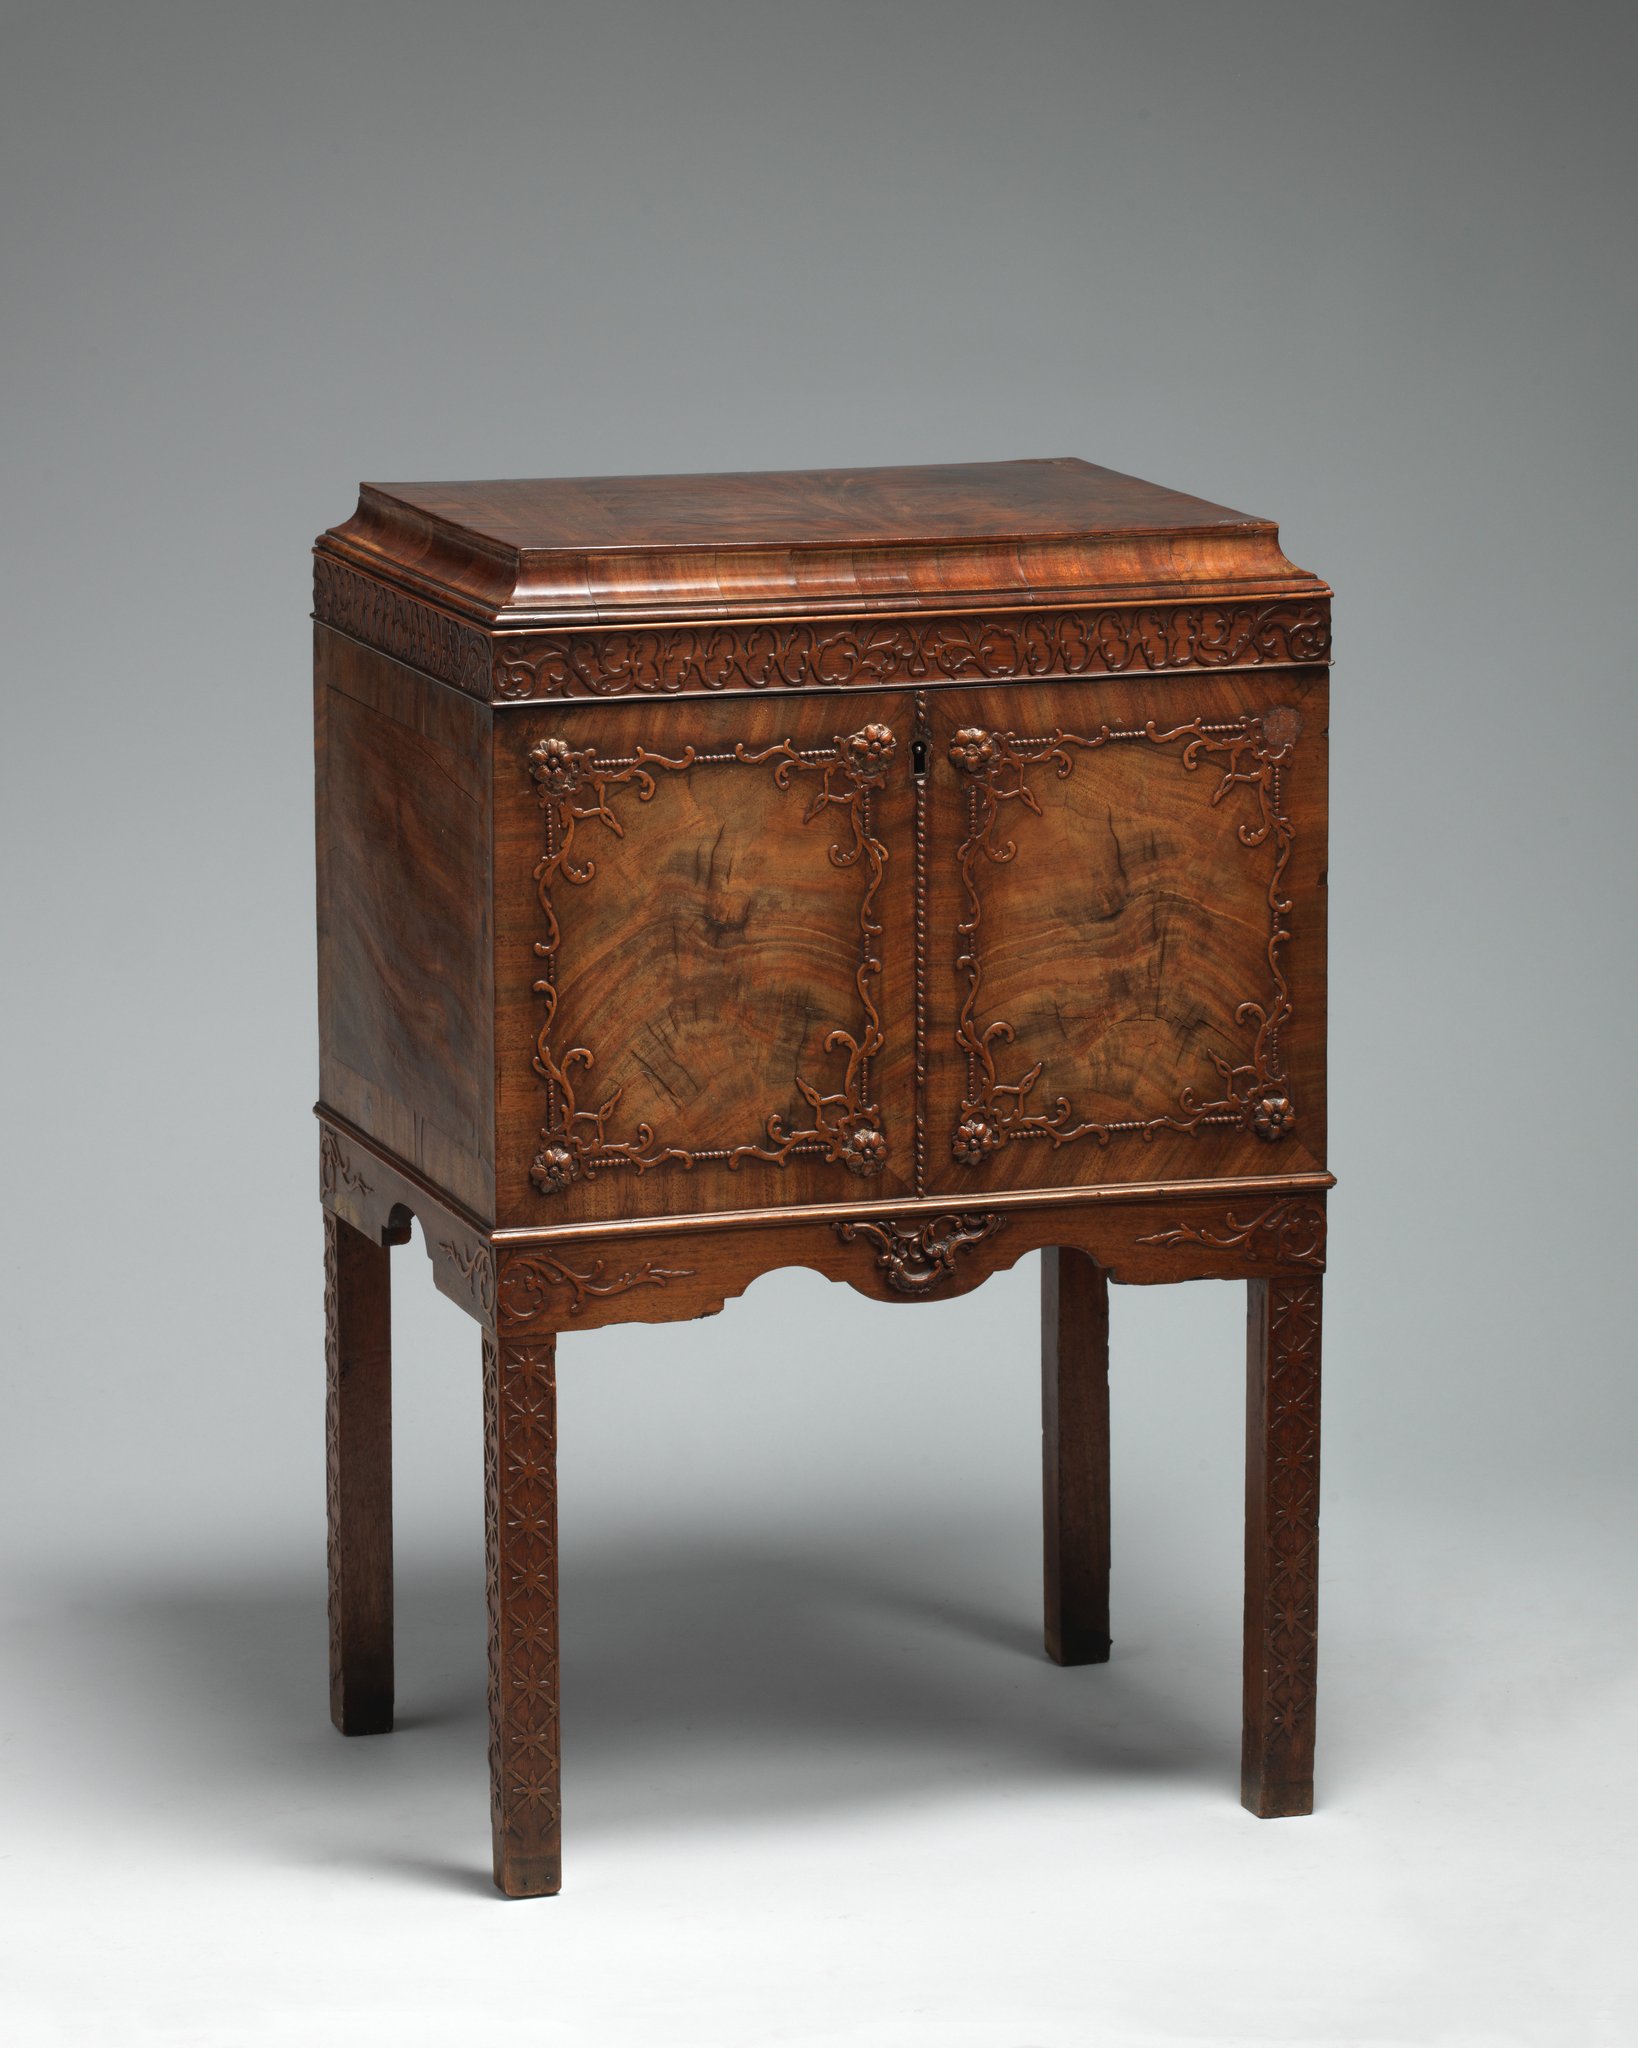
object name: cabinet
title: Cabinet (cellaret)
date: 1760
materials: wood